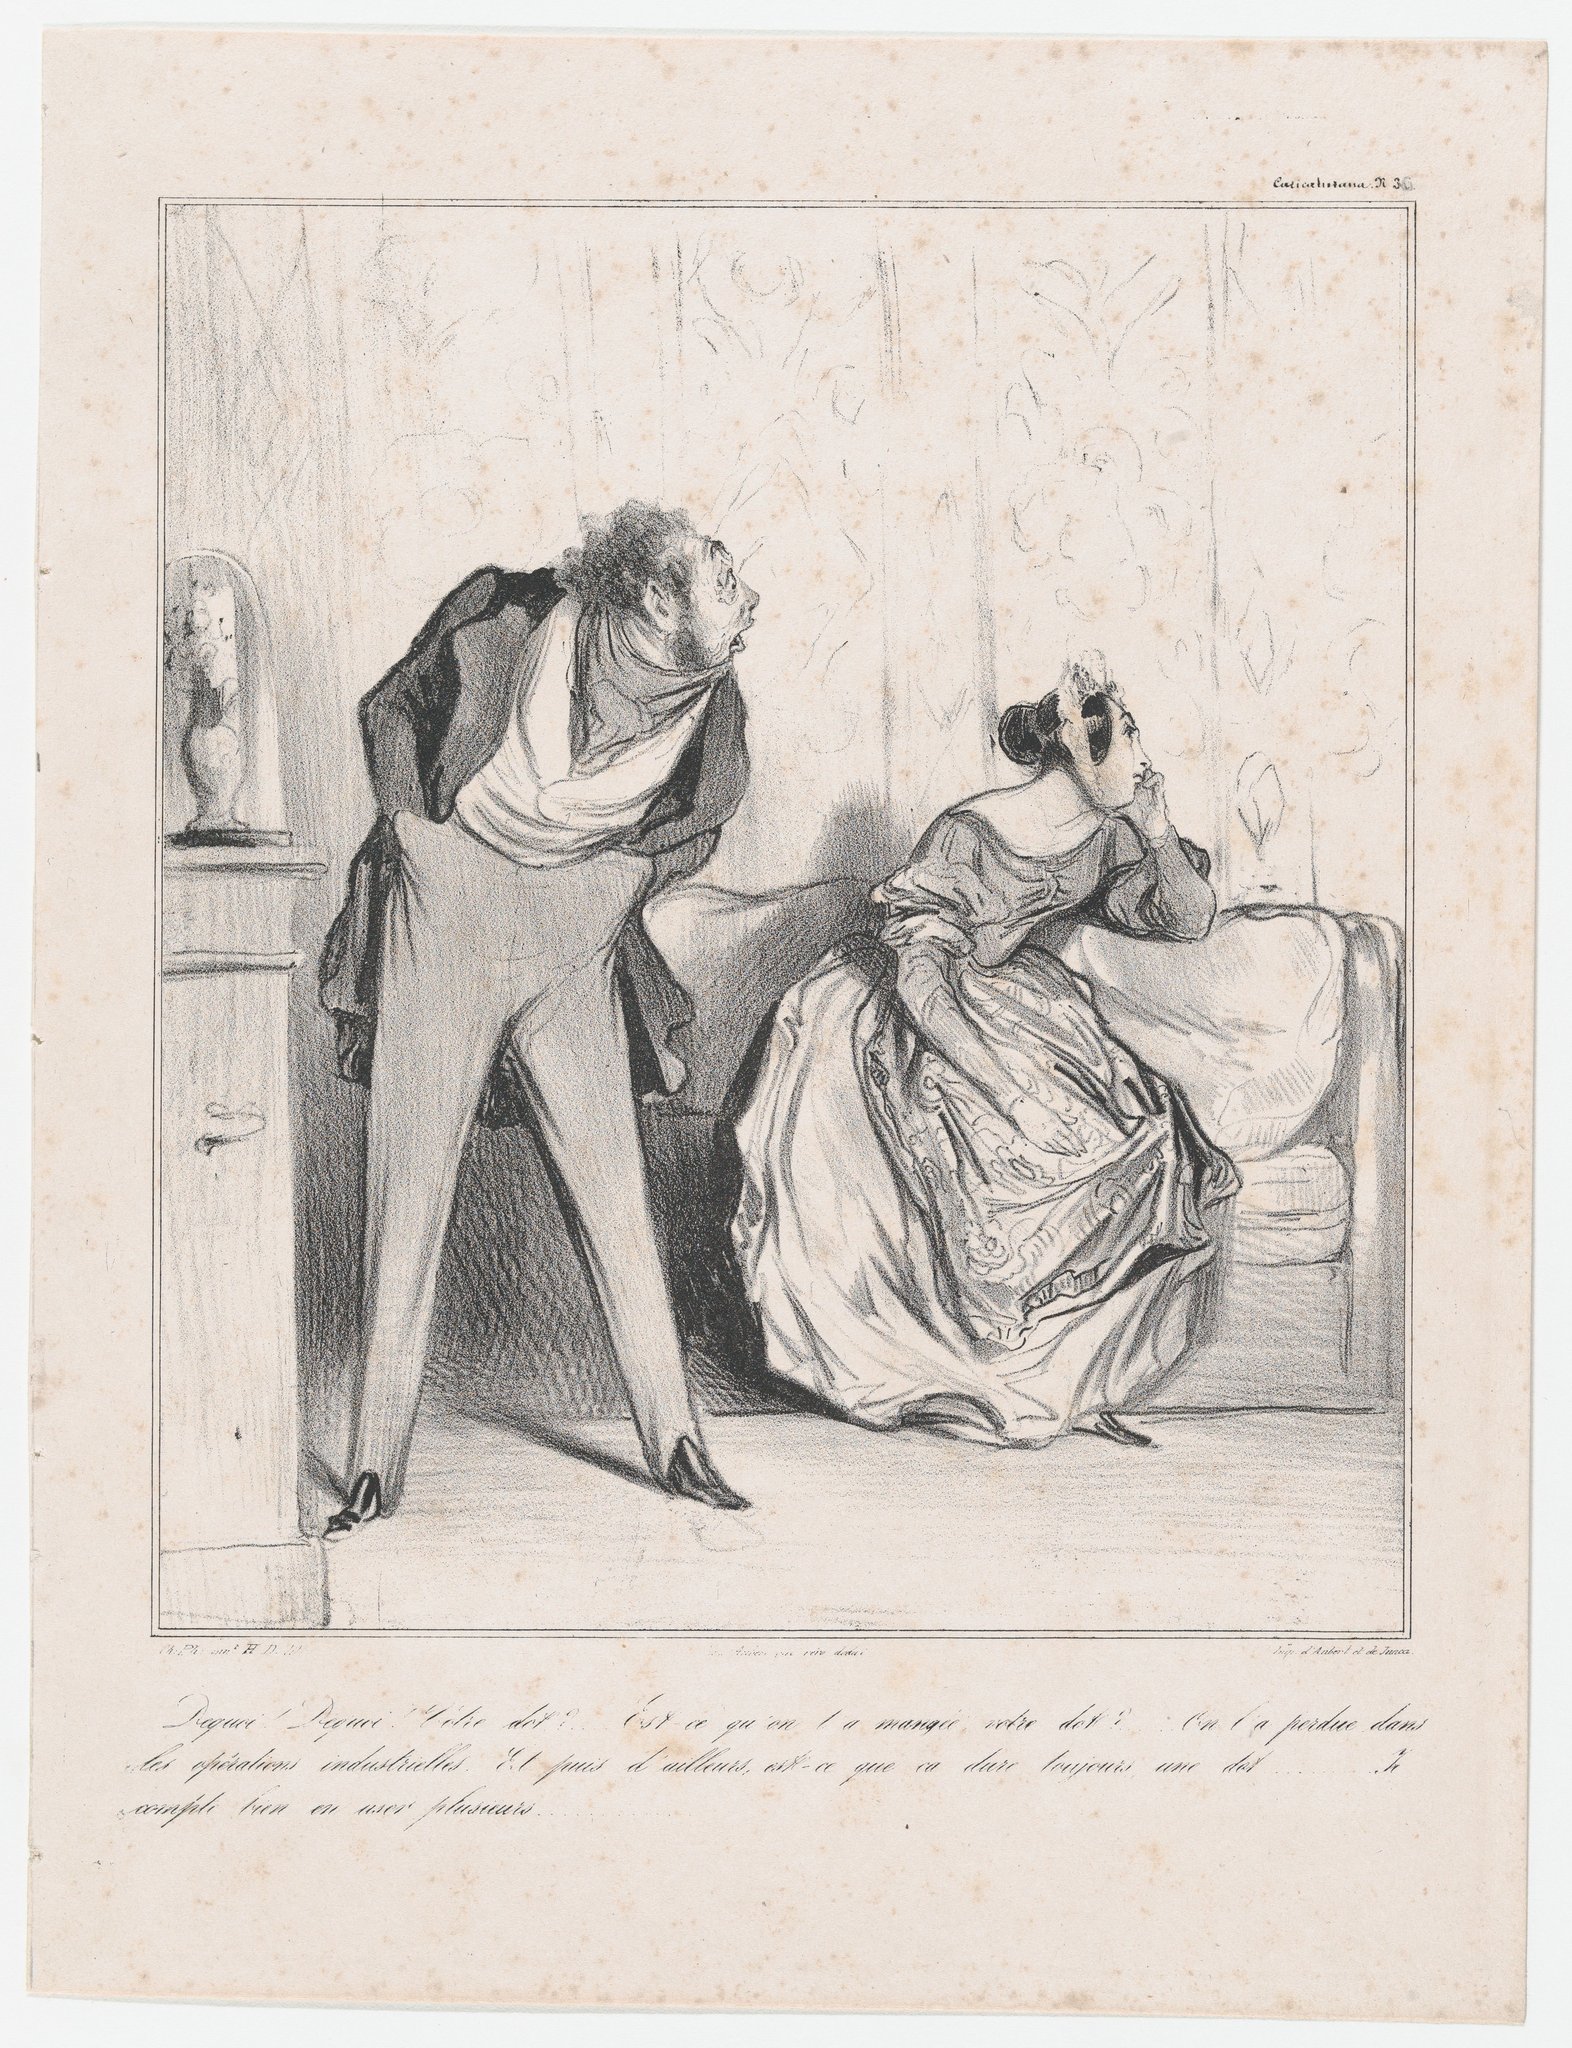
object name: print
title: Plate 36: Well? Well? What about your dowry?, from 'Caricaturana,' published in Les Robert Macaires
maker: honoré daumier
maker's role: artist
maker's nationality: french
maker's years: 1808-1879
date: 1838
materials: paper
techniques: lithograph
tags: men,women